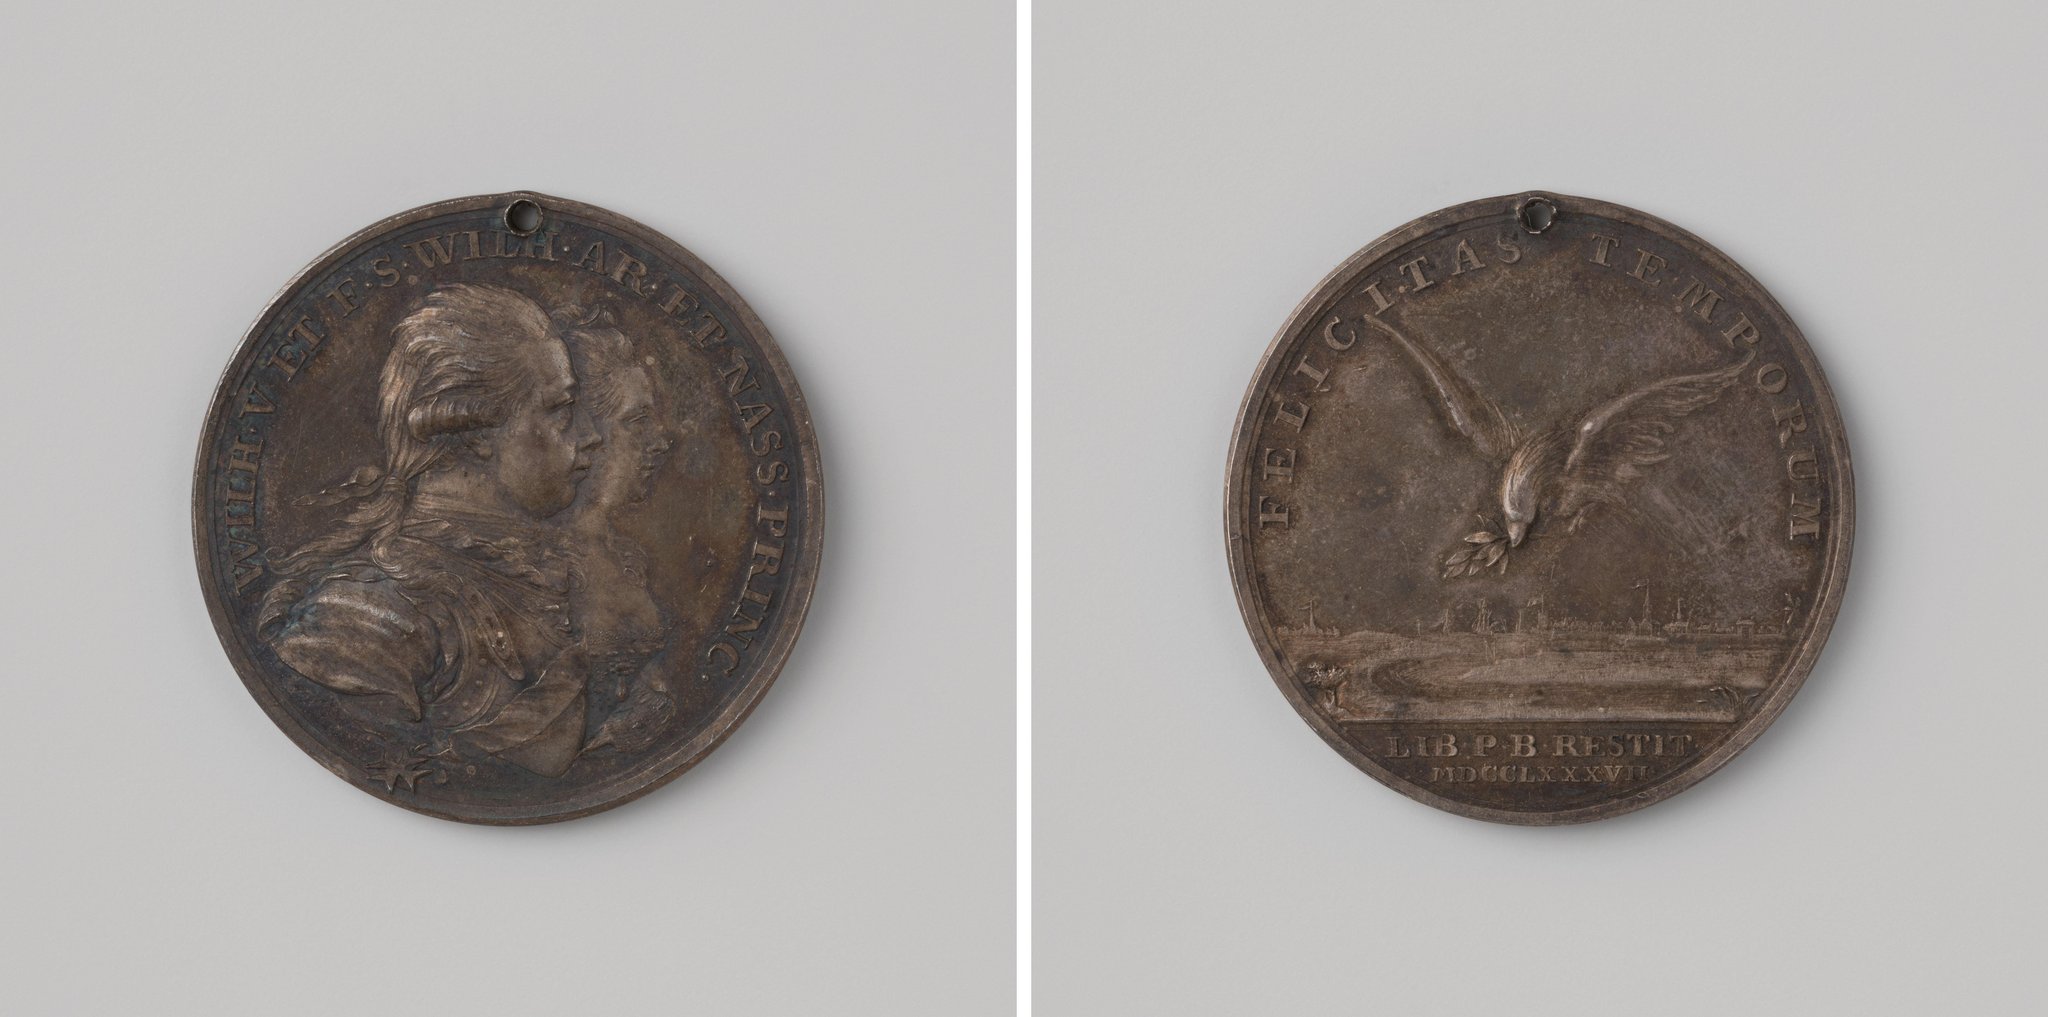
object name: history medal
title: Herstel van Willem V als erfstadhouder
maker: Anonymous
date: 1787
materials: silver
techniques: striking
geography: netherlands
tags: the hague, william v (prince of orange), painter, wilhelmina of prussia (princess of orange)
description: Zilveren penning met gat erin. Voorzijde: borststuk man en vrouw binnen omschrift. Keerzijde: adelaar met olijftak in bek, zwevend boven landschap, waarin rivier en stad zichtbaar zijn binnen omschrift; afsnede: opschrift